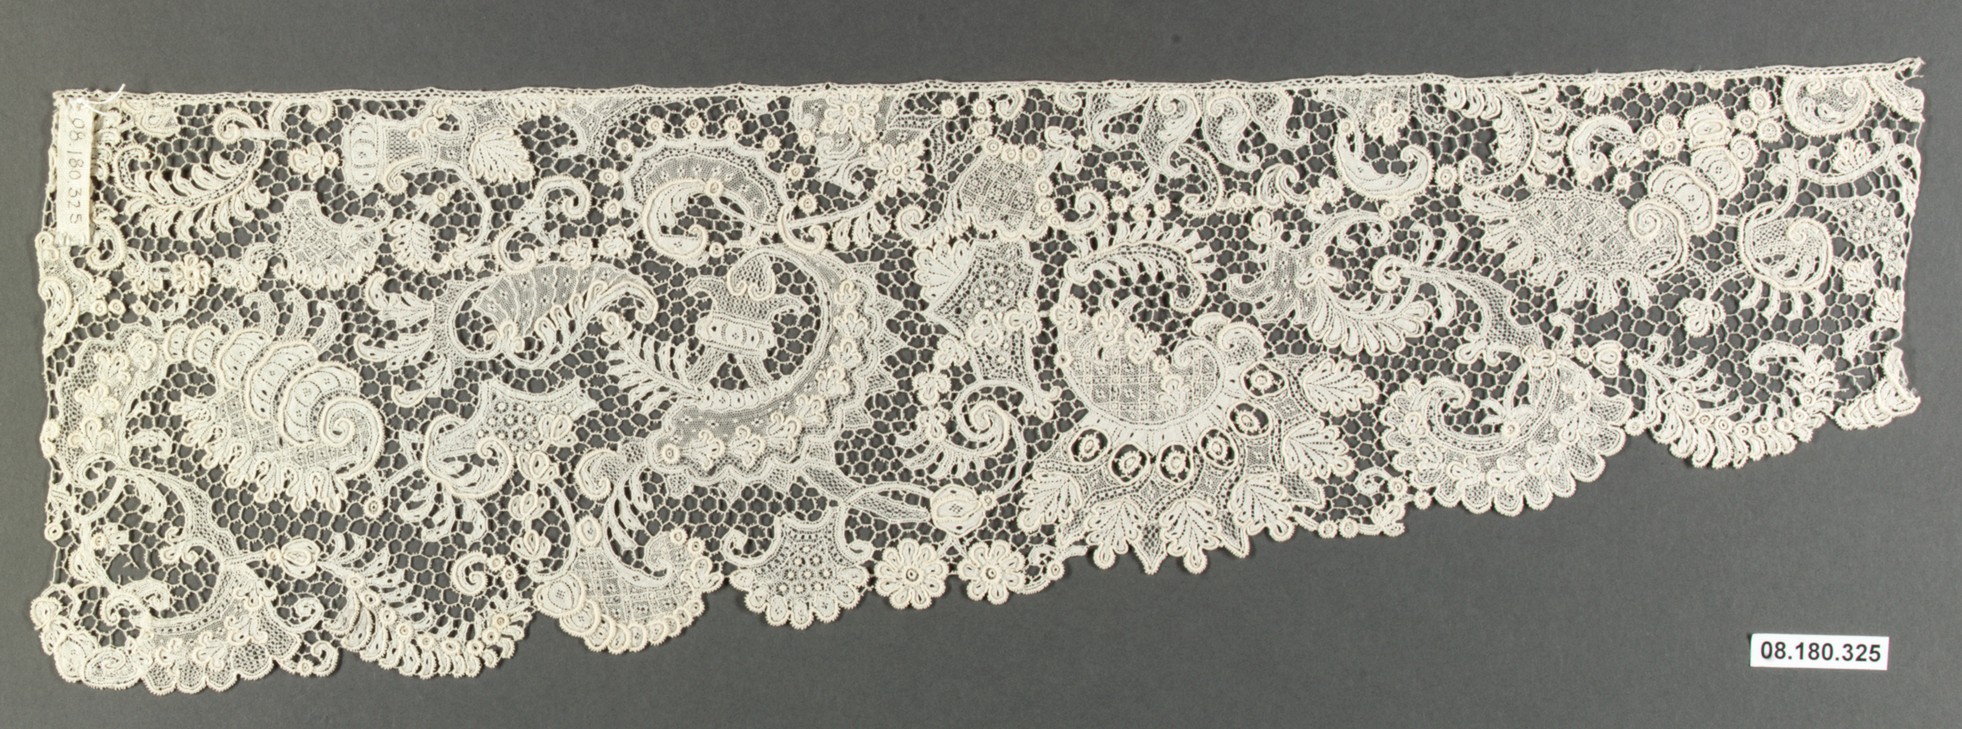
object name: fragment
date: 1701-1800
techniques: lace